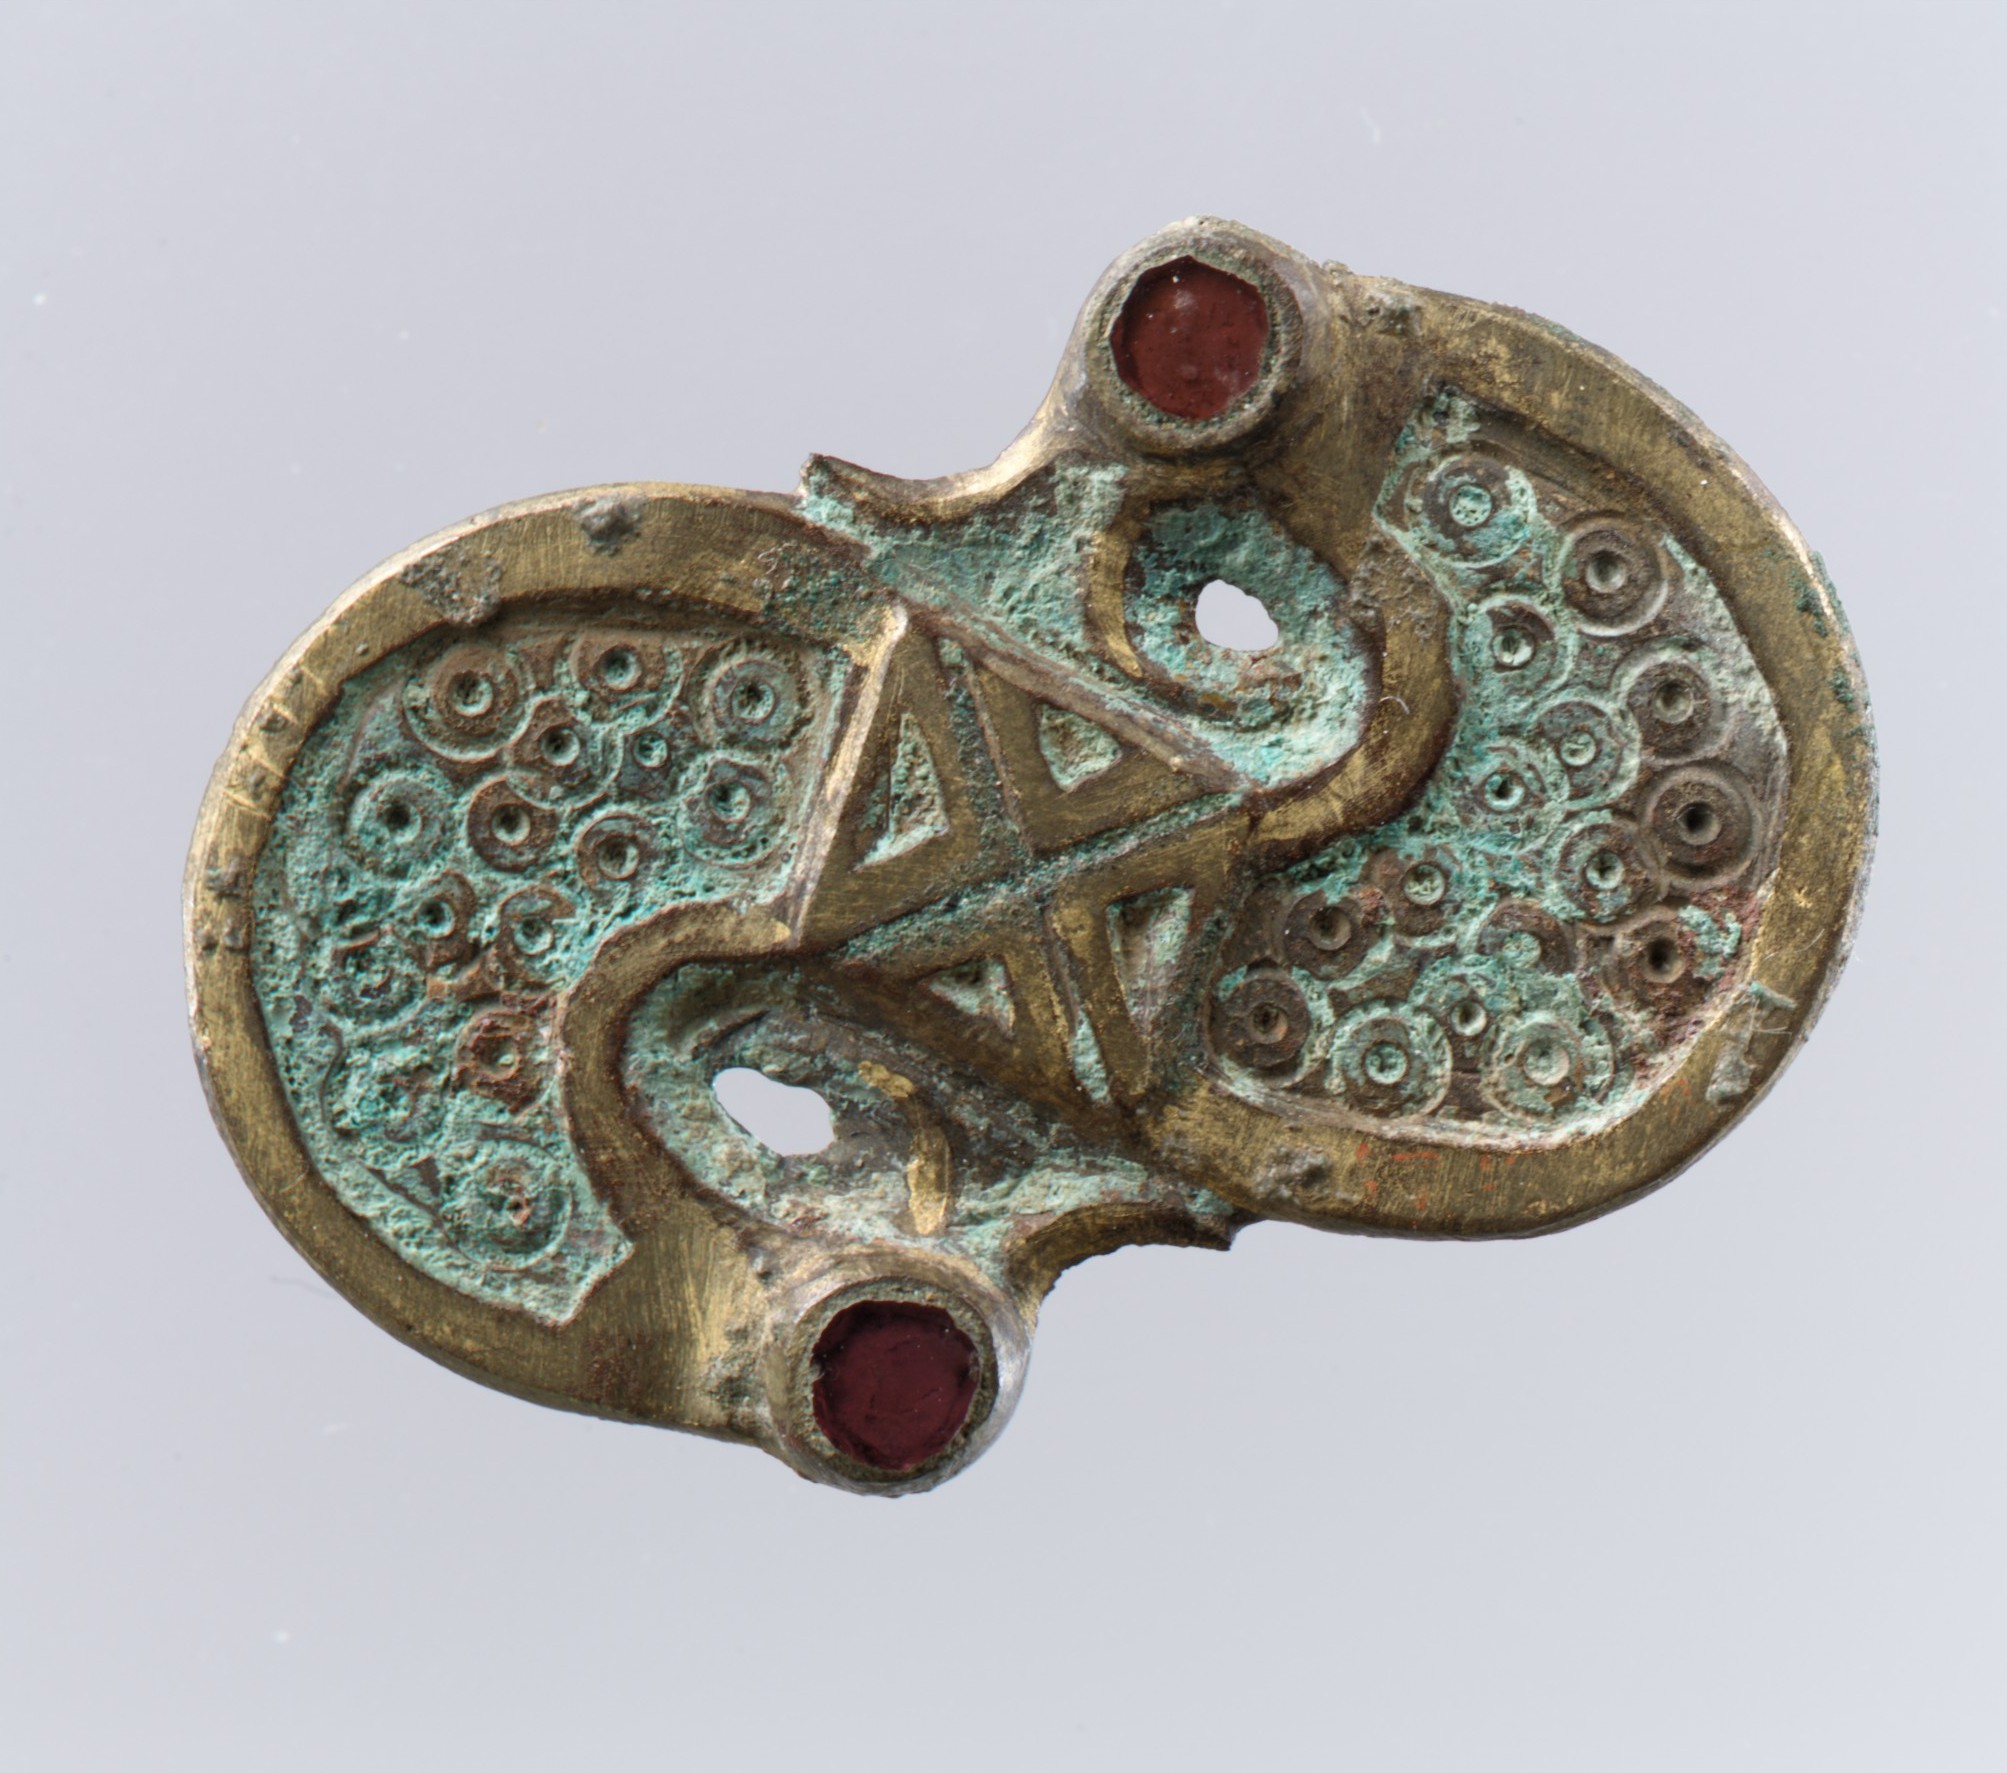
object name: brooch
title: S-Shaped Brooch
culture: frankish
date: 501-600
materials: copper alloy, gemstone